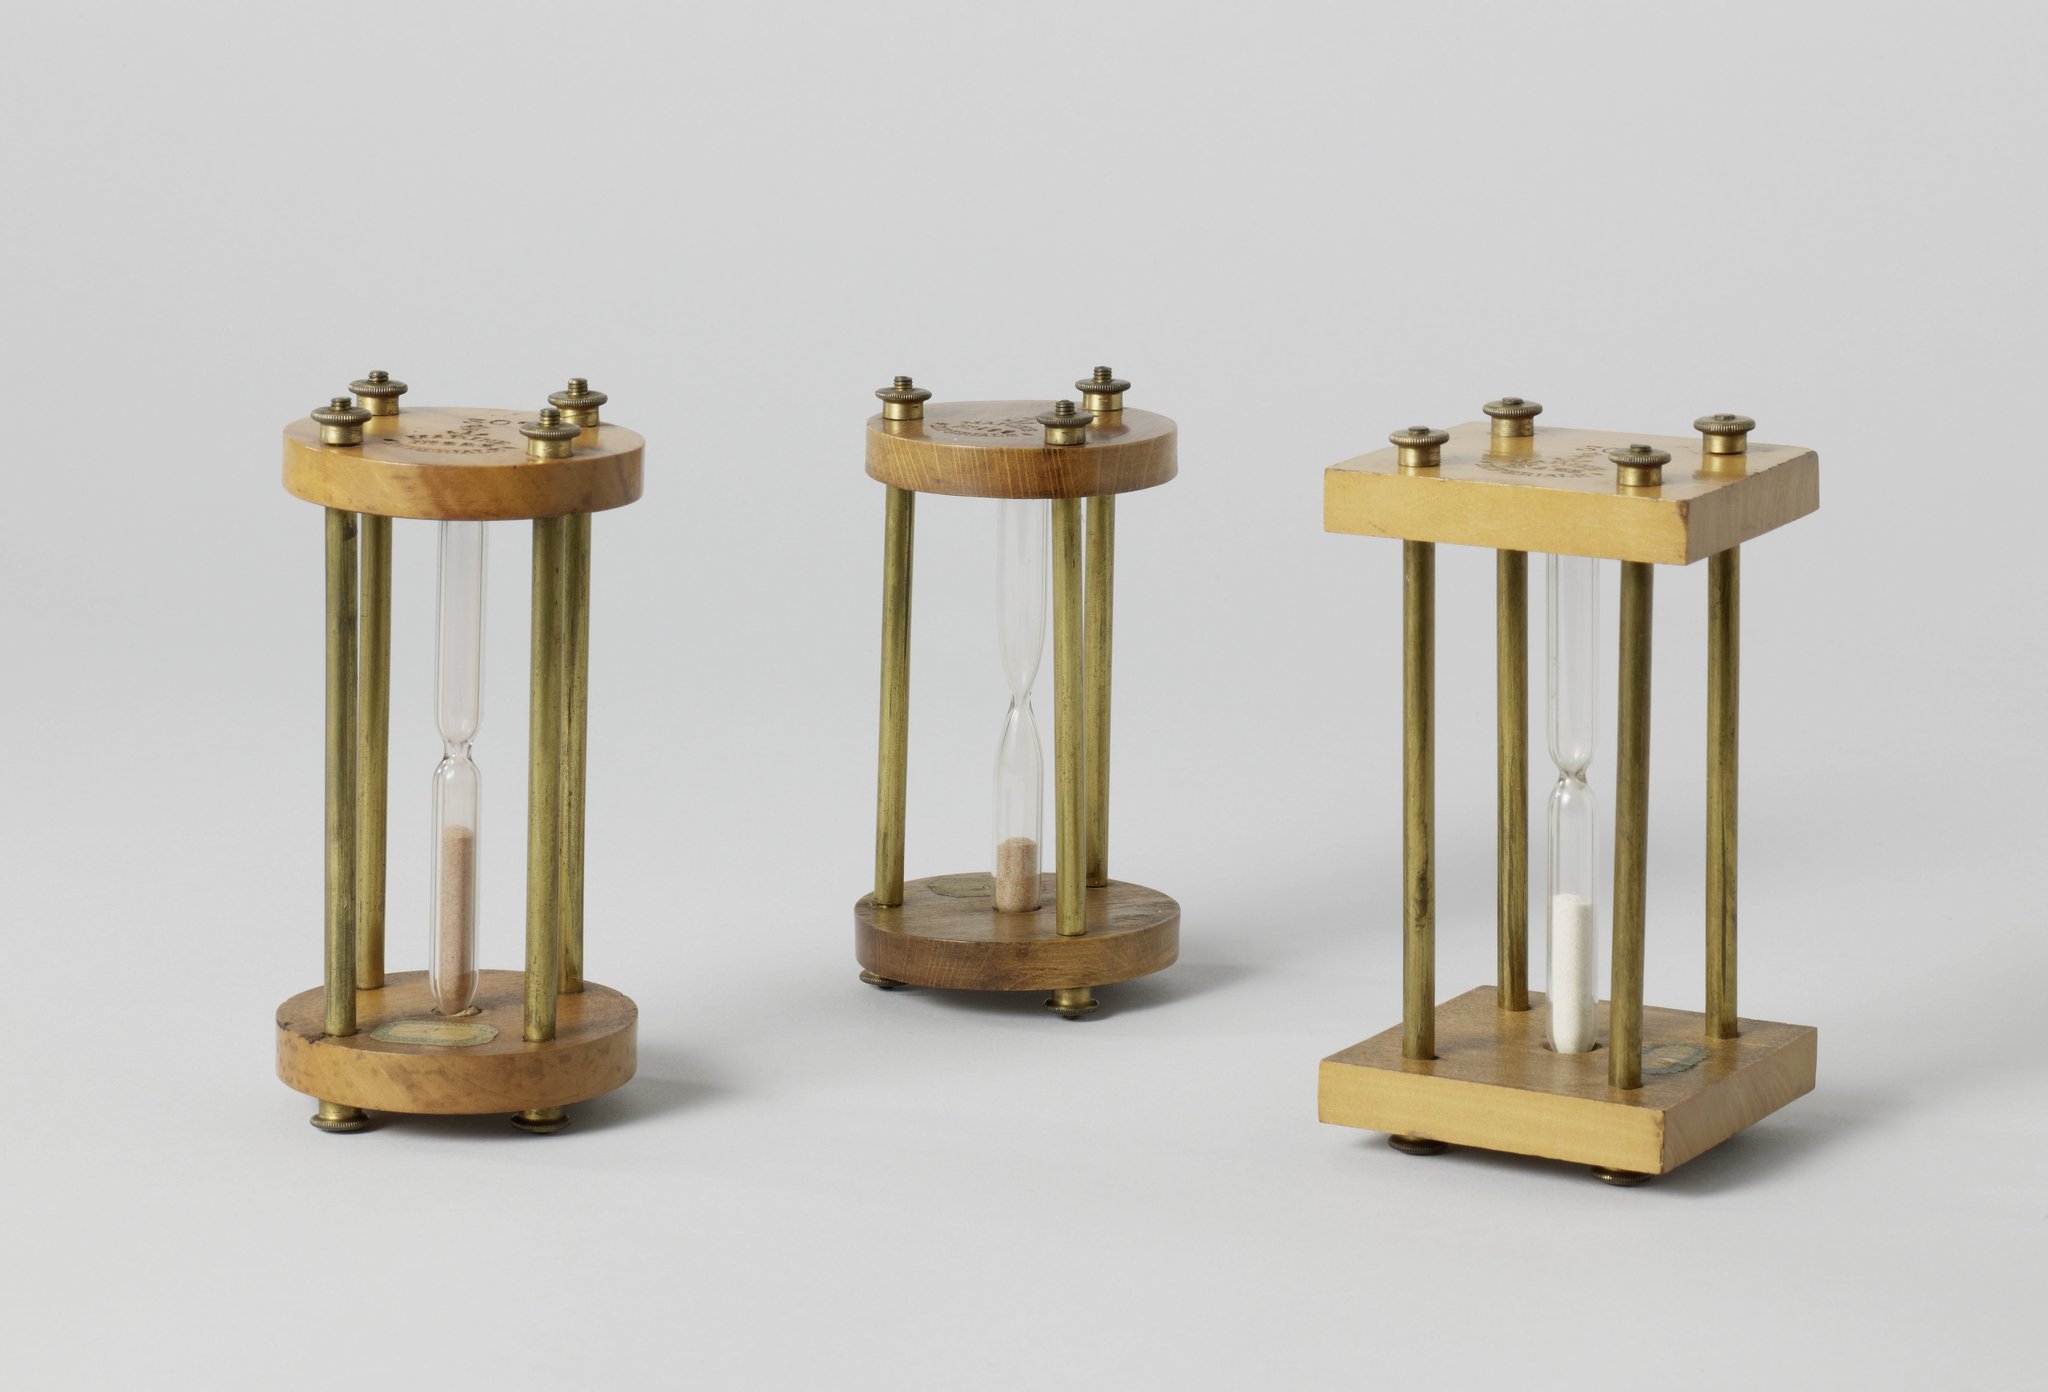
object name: sand glass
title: Sand Glass of 15 Seconds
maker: Anonymous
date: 1860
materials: brass, cork, glass, mineral, wood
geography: france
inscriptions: inscription, on the top: ‘15 S / MARINE / Nº 199 / IMPERIALE’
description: In totaal werden vier logglazen in 1862 door de heer De la Marche, hydrografisch ingenieur van de Franse Marine, aan de Nederlandse Marine aangeboden; een glas van 15 seconden is verloren.